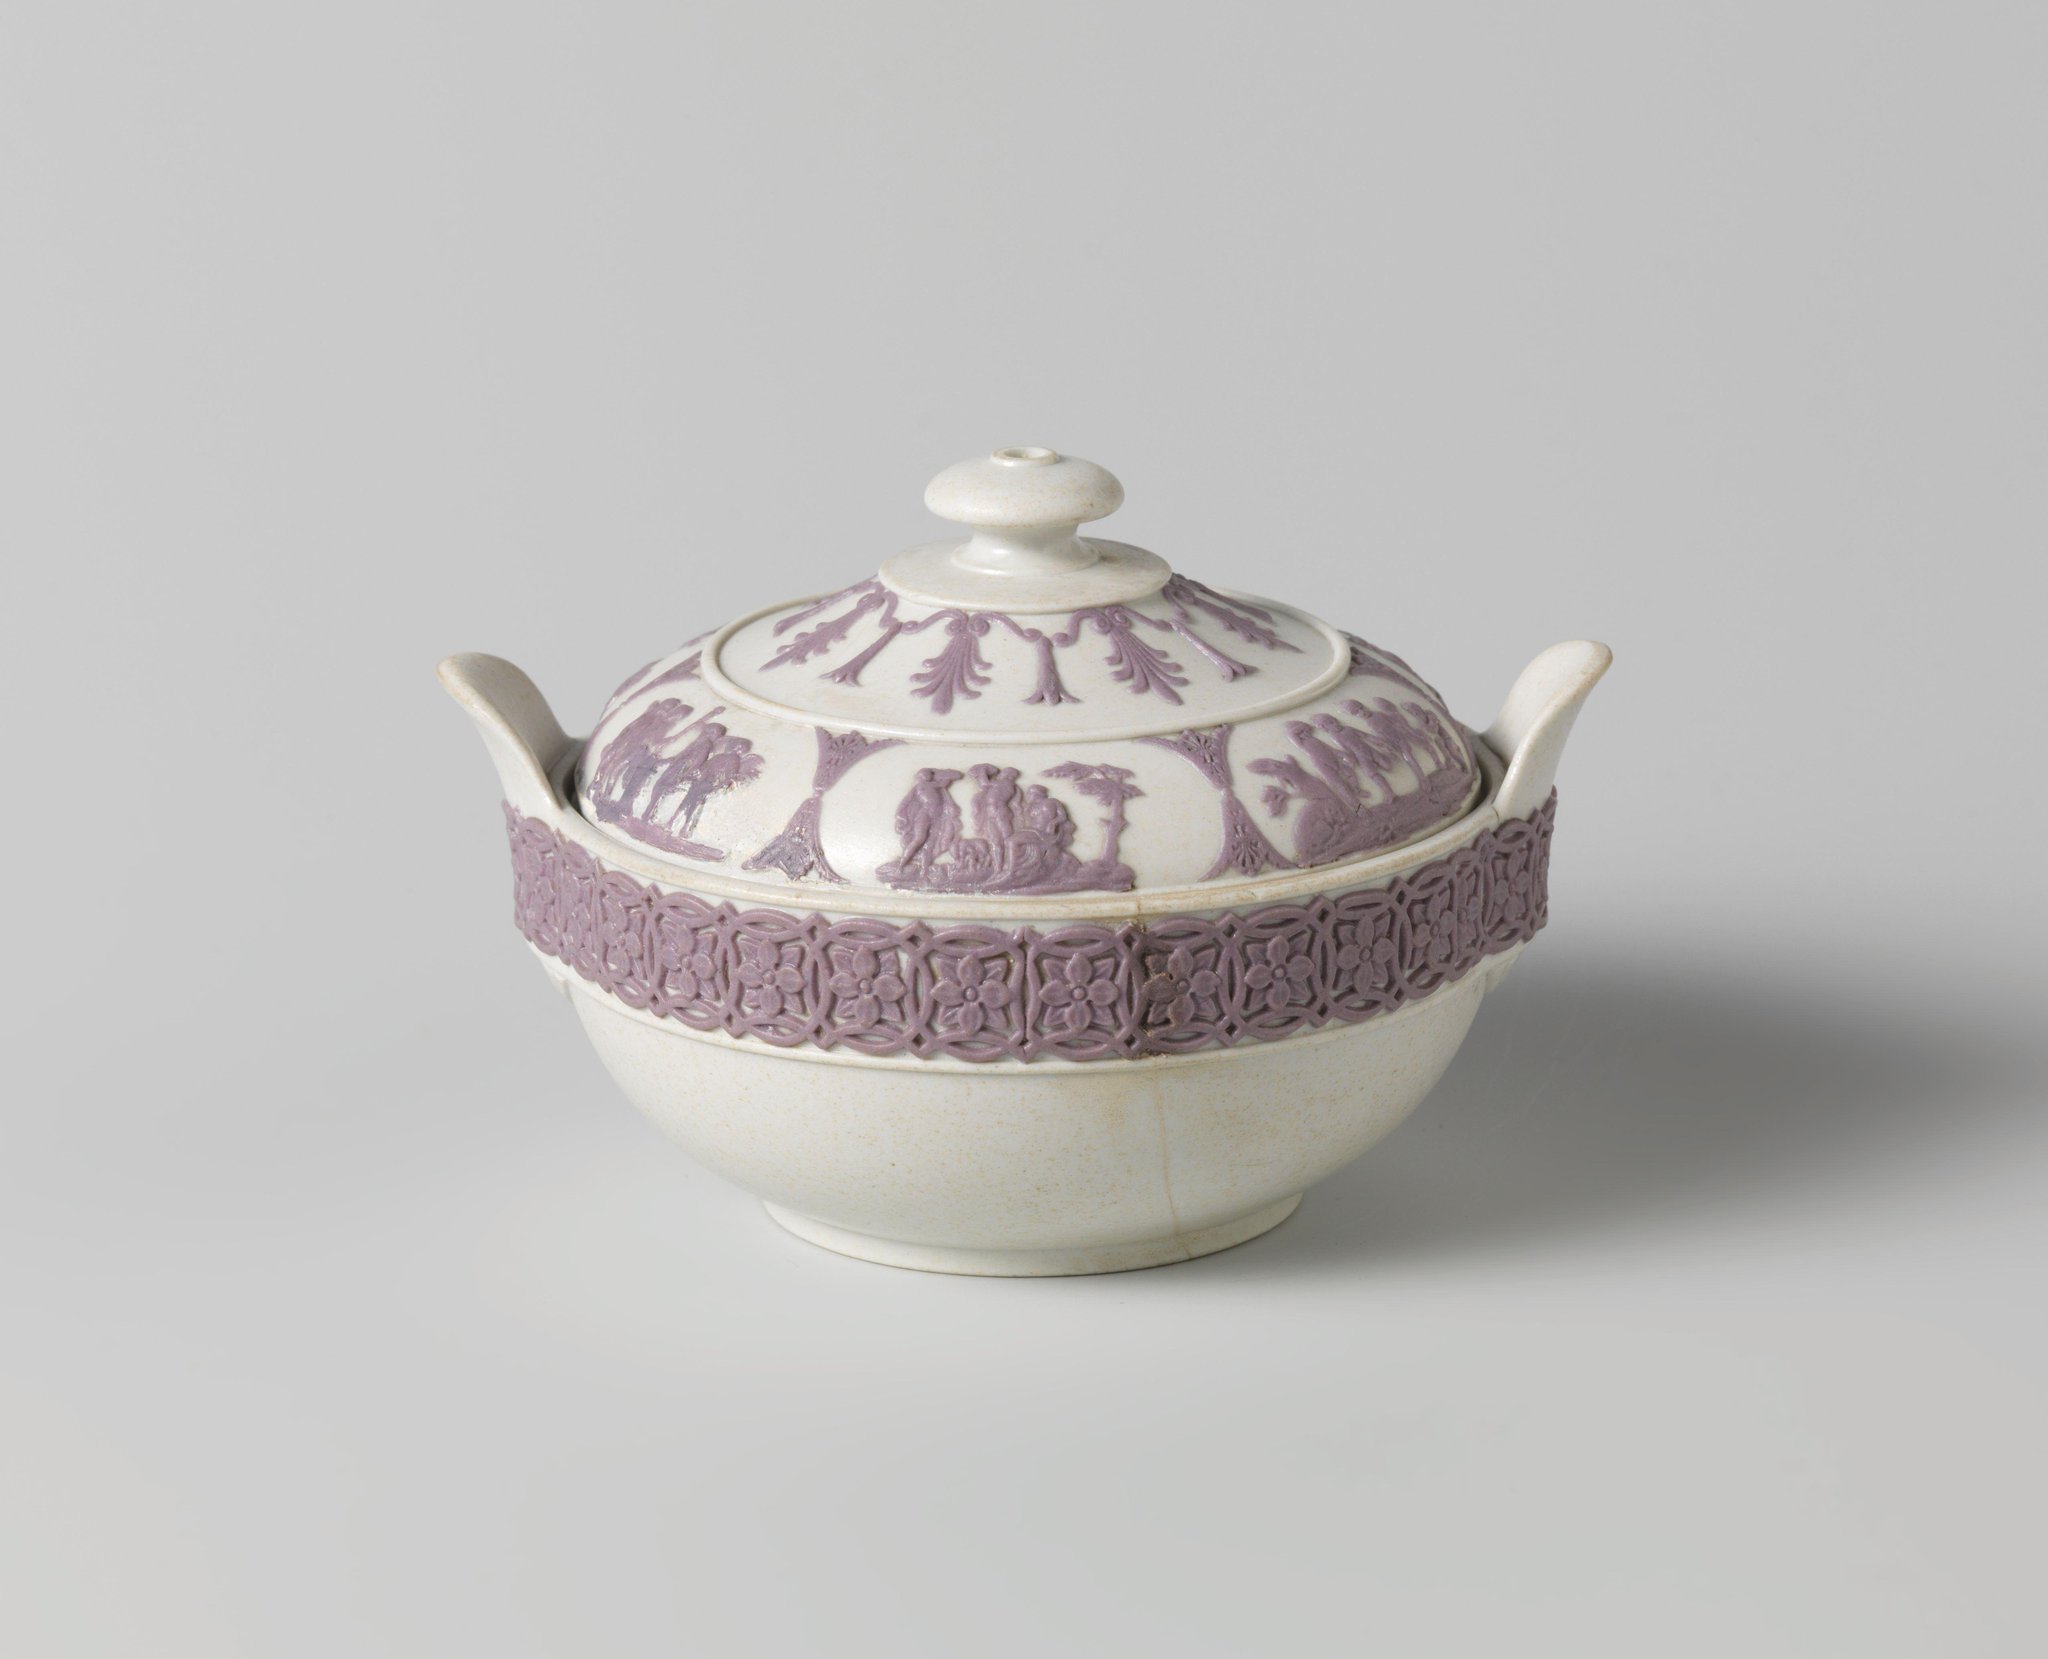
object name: pot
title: Deksel van steengoed, versierd met paarse applieken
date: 1790-1810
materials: stoneware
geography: england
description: Het deksel is gewelfd en heeft een geprofileerde knop. Het deksel is versierd met drie groepen van genii en drie mythologische taferelen.